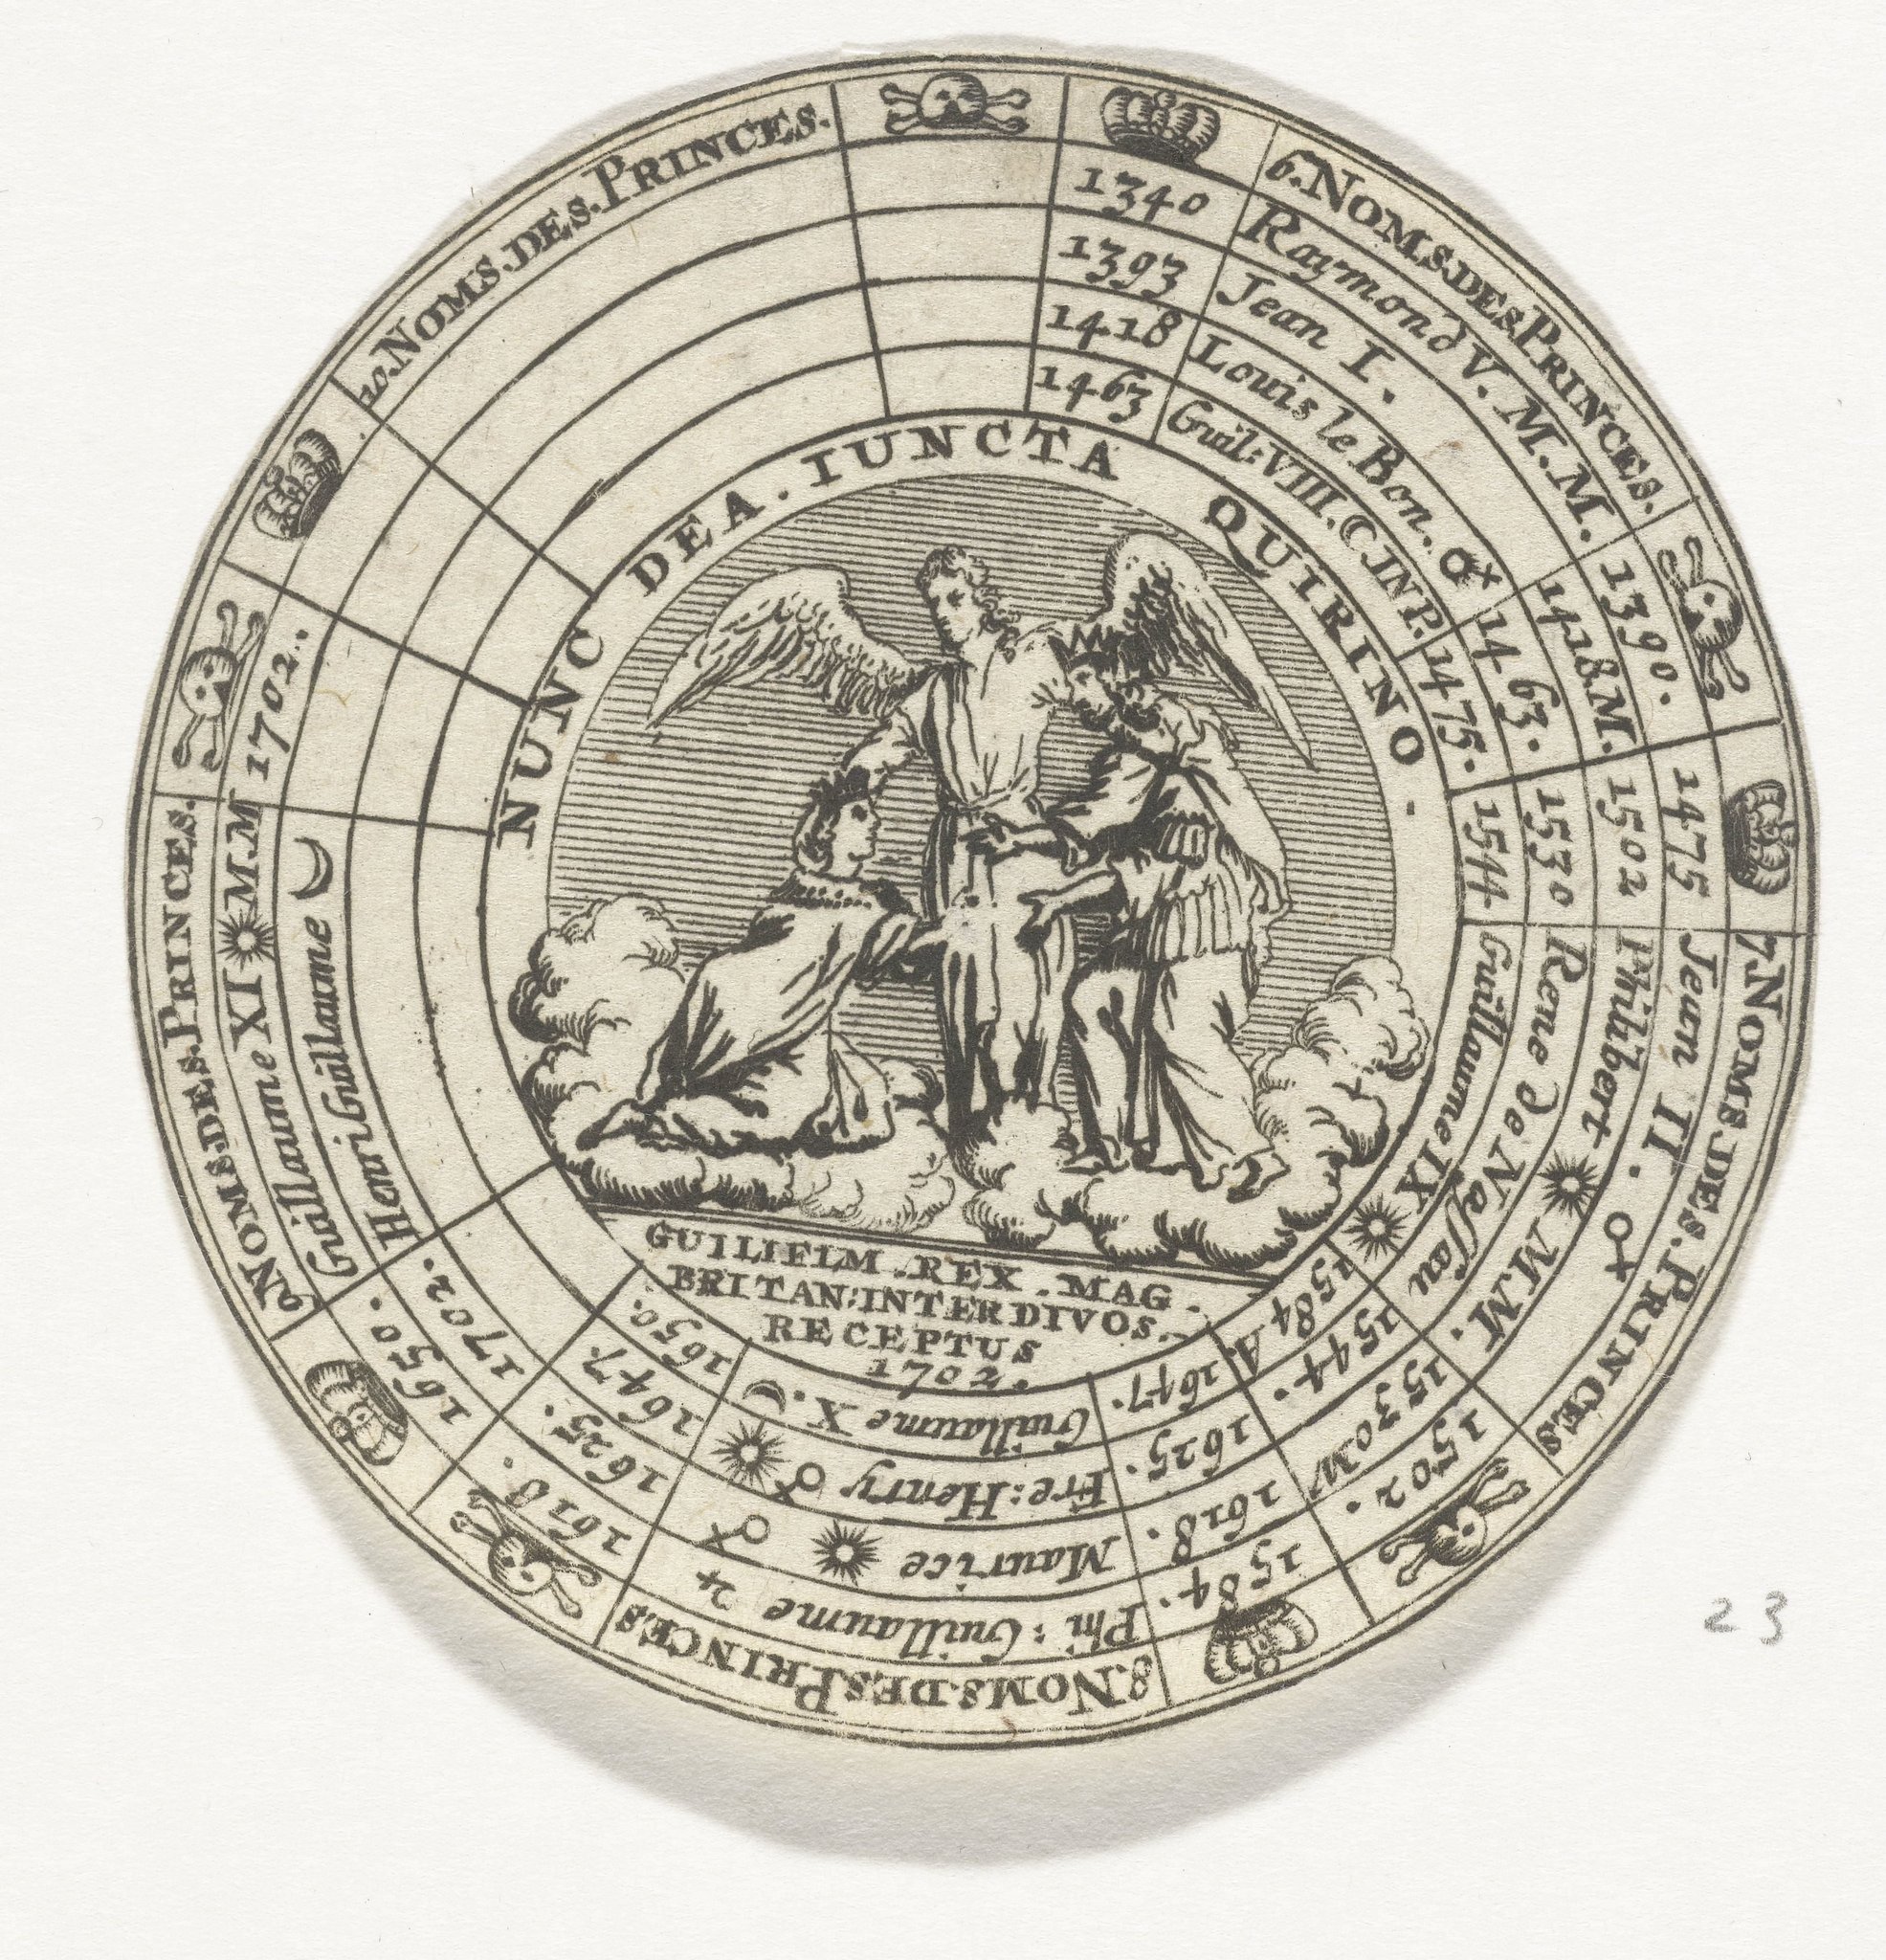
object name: print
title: Penning met een embleem en de namen van de prinsen van het huis Oranje-Nassau.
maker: Anonymous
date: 1702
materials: paper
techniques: etching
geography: amsterdam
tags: william iii (prince of orange and king of england, scotland, and ireland), london, maria ii stuart (koningin van engeland, schotland en ierland), queen, abstract ideas and concepts (+ emblematical representation of concept), king, seal (symbol of sovereignty), angels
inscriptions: number: ‘24’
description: Ontwerp van een ronde penning met, in vijf concentrische cirkels, de namen van de prinsen van Oranje-Nassau en hun regeringsjaren, beginnende bij prins Raymond V en eindigend bij prins Willem III van Oranje. In het midden van de penning een embleem waarin een koningin knielt voor een koning en een engel. Het embleem draagt als motto:"Nunc dea Juncta Quirino".